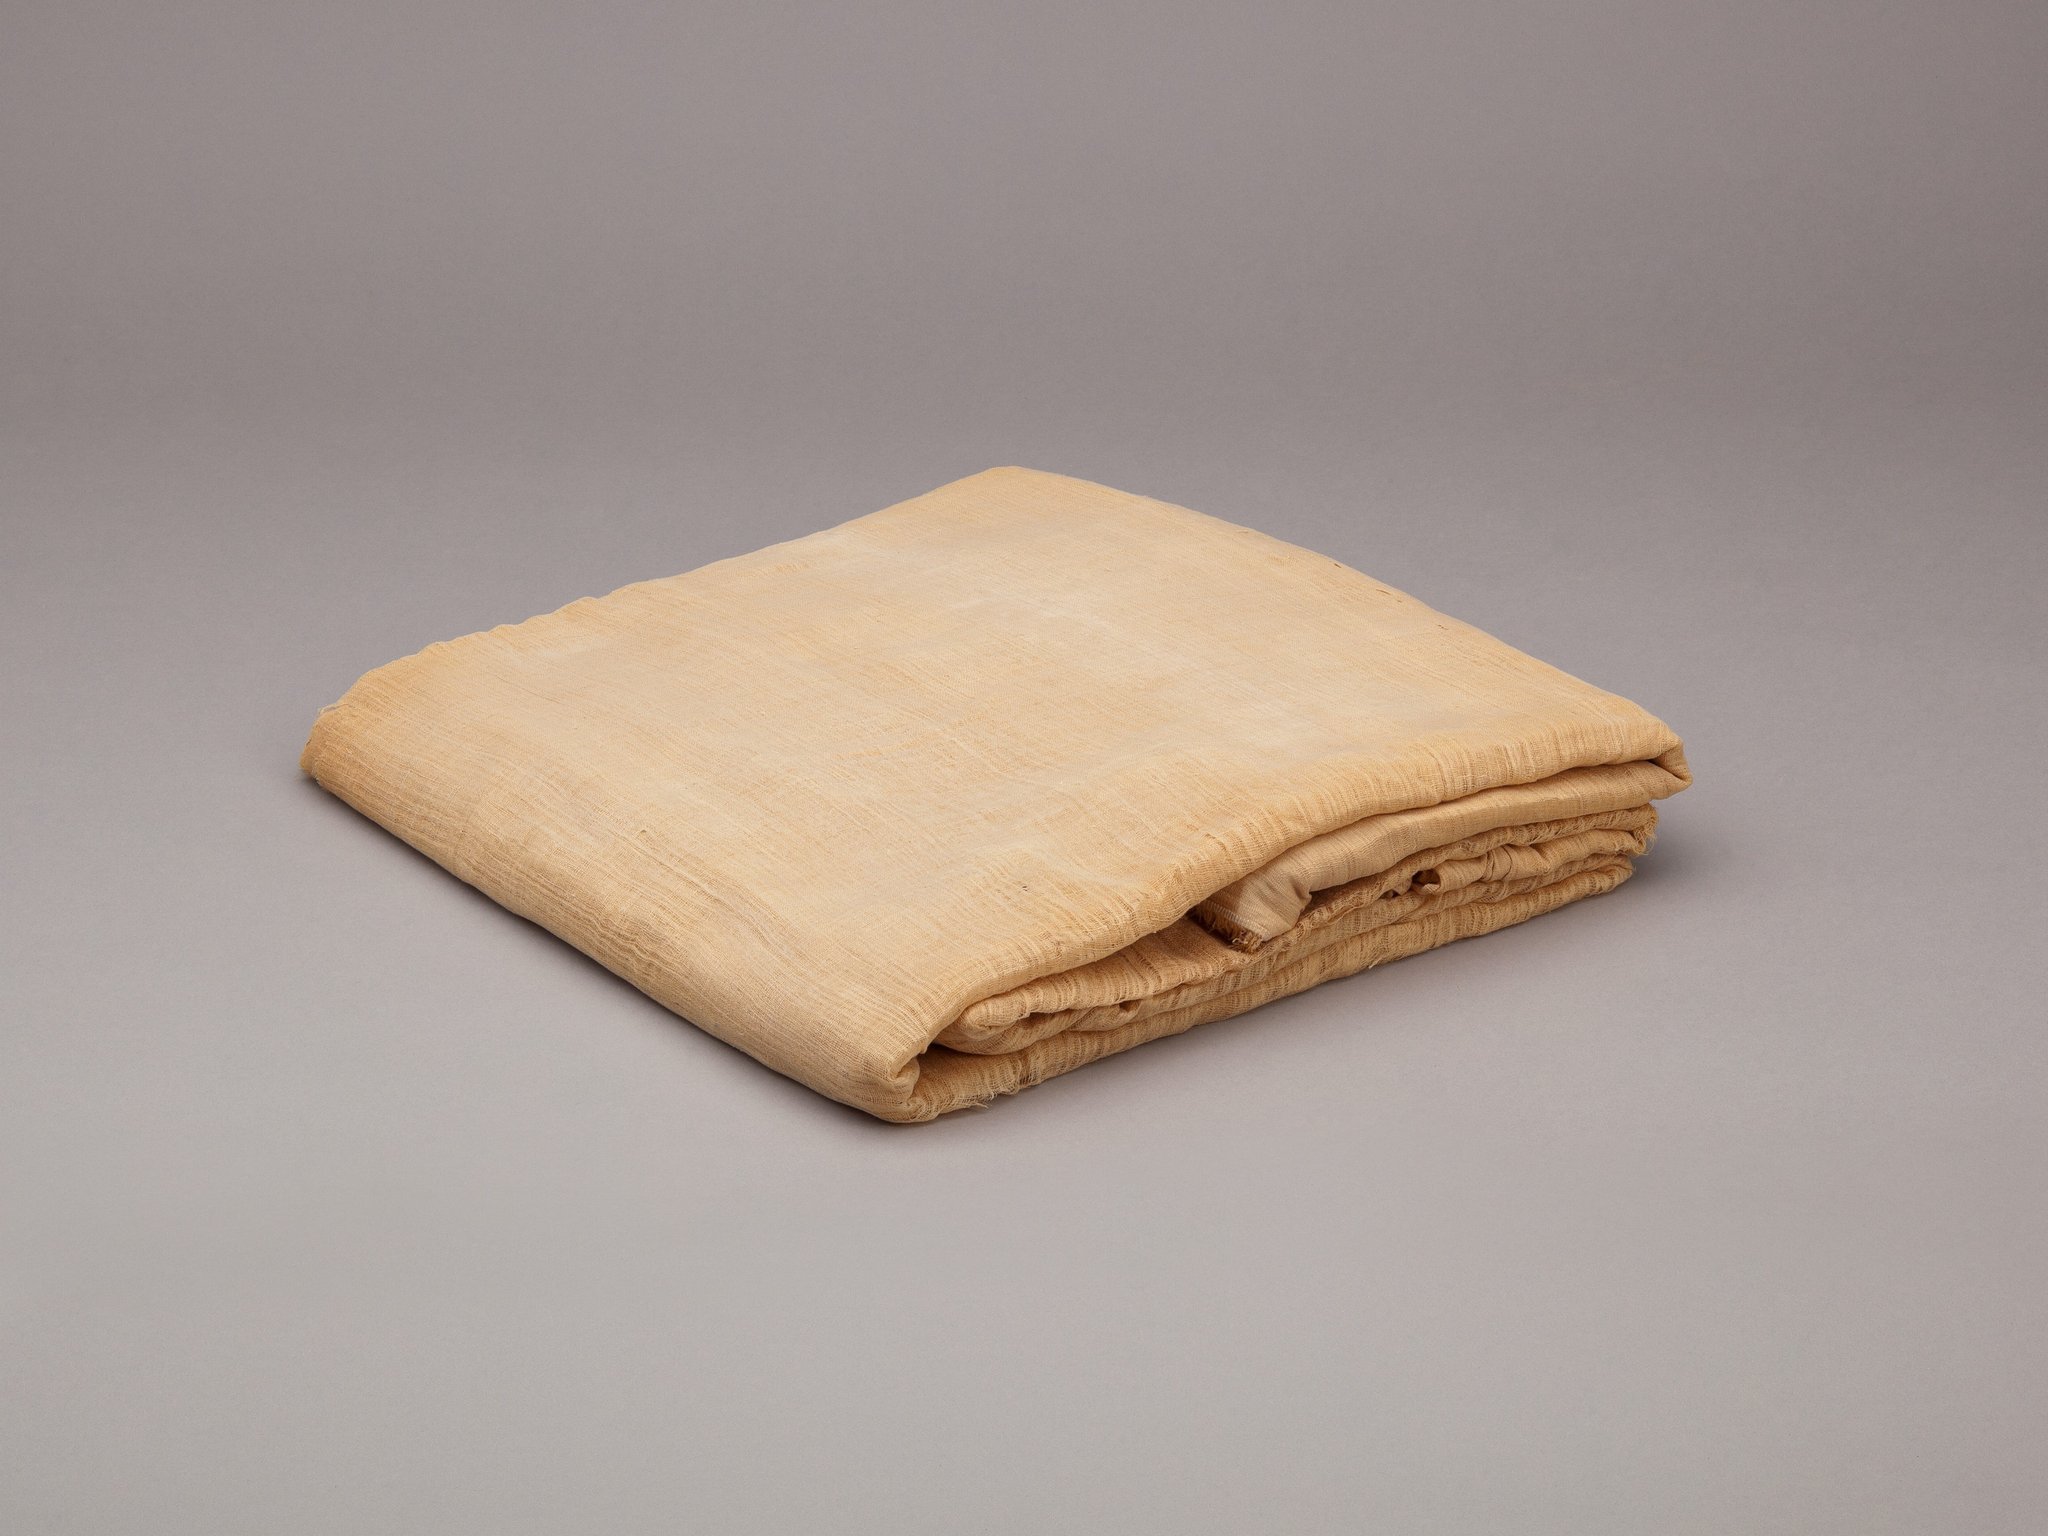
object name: linen mark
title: Sheet, woven linen mark, medium spin, medium weave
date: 1492-1473 BCE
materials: linen, wax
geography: egypt